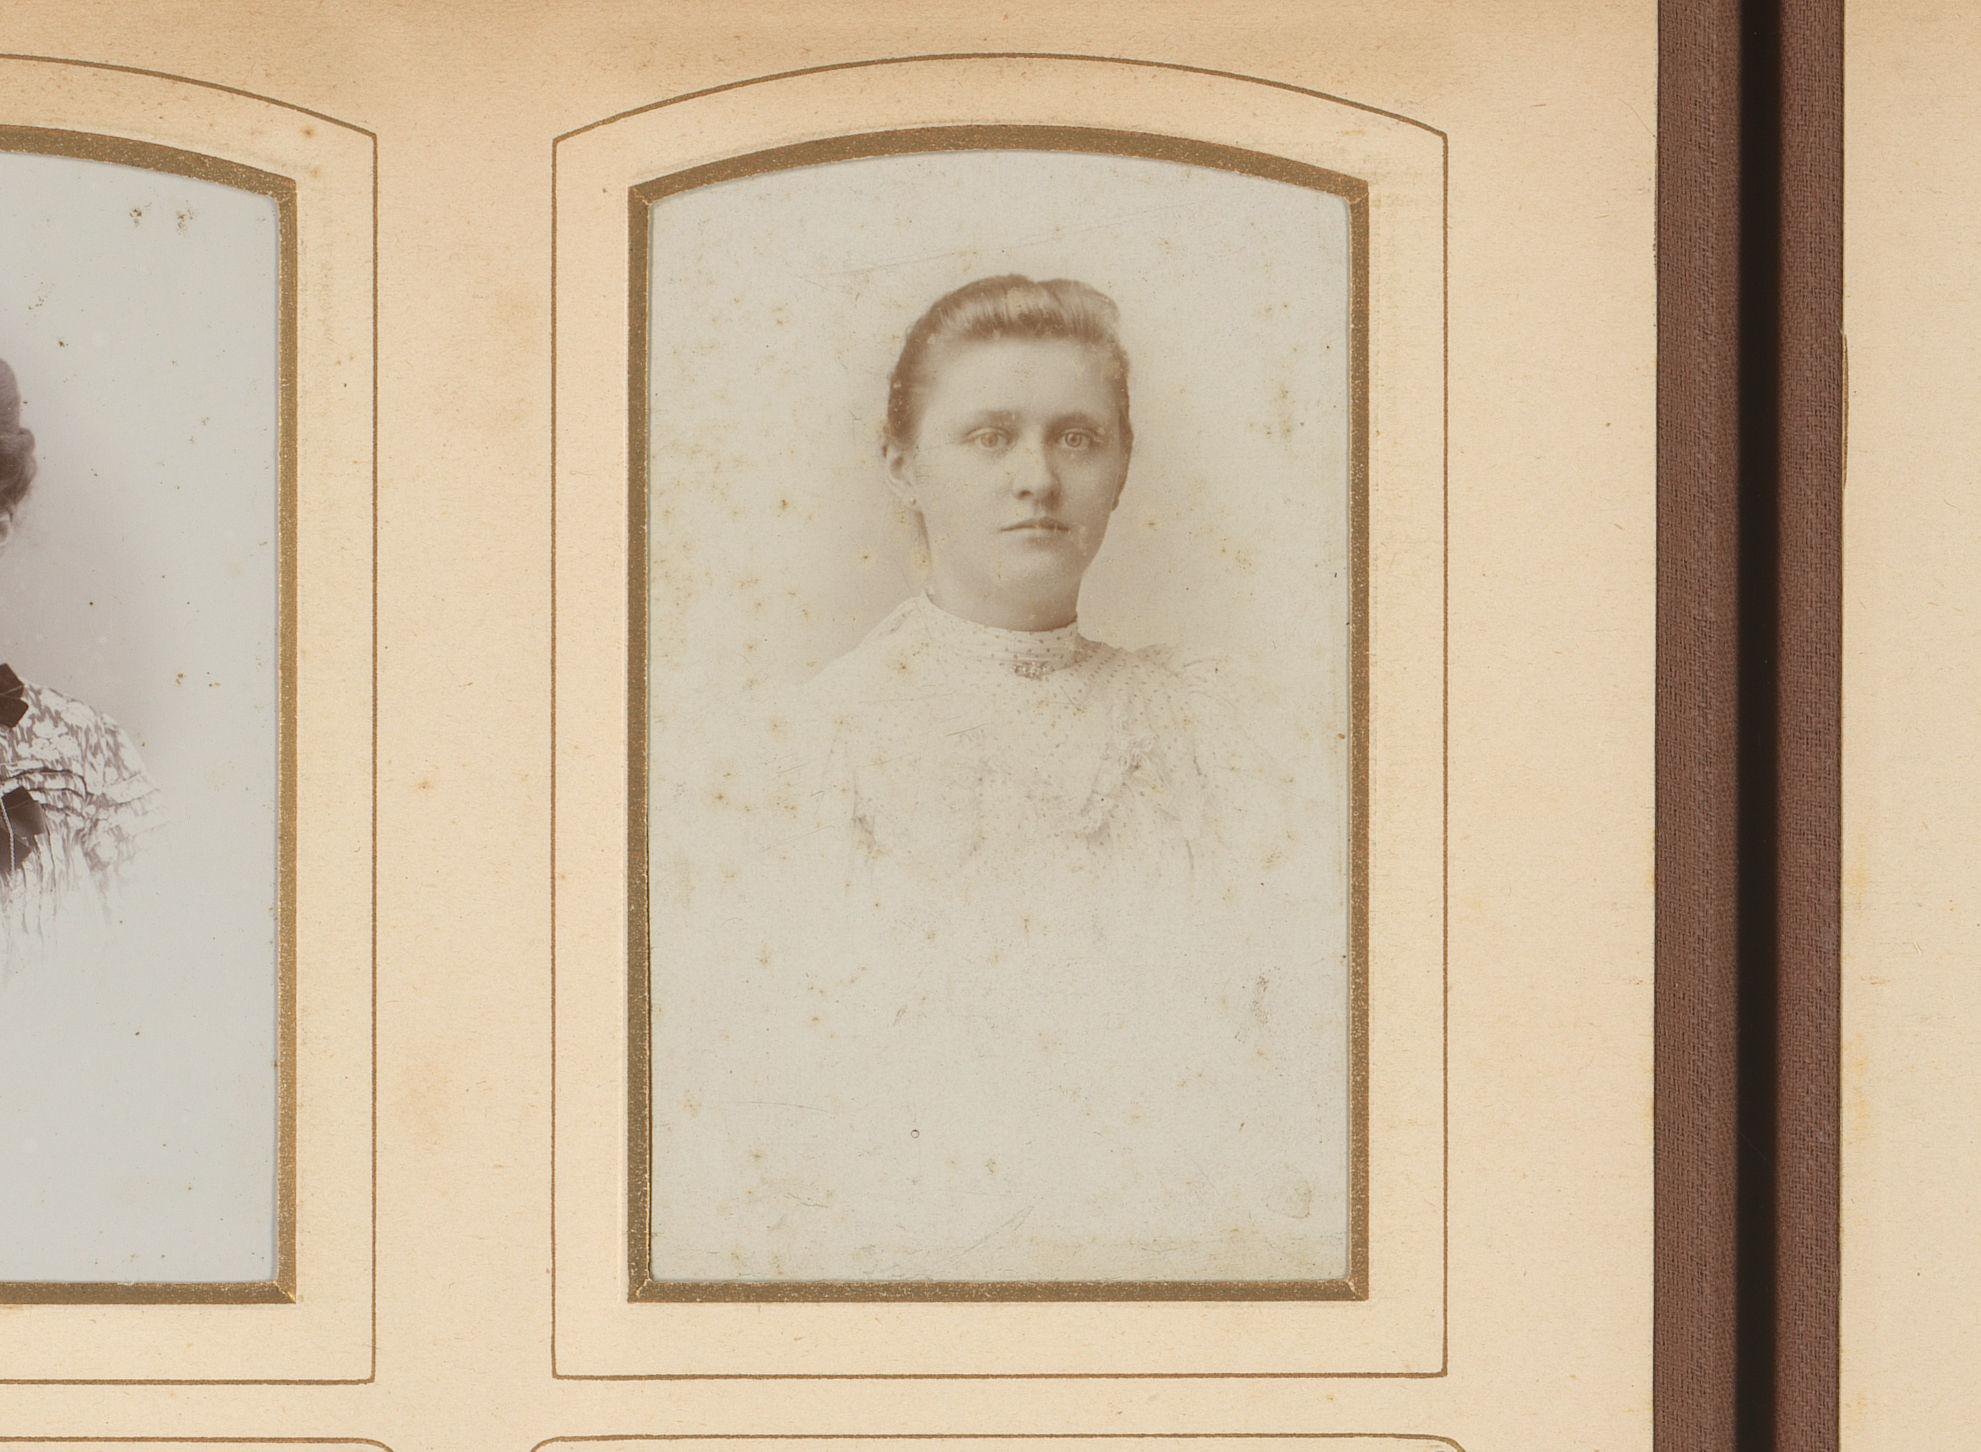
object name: photograph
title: Portret van een jonge vrouw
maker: h. van der zijl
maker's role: fotograaf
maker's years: 1852-1937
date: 1886-1908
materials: cardboard, photographic support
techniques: collodion silver print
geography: amsterdam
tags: adolescent, young woman, maiden, historical persons - bb - woman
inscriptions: number: ‘12.’, inscription: ‘Photographie/ Parisienne/ H. van der Zijl/ Amsterdam/ 60 Nieuwendijk 60./ over Raamskooi en Kapelsteeg./ Gelieve op Voornaam H/ en Huisnummer 60 te Letten’